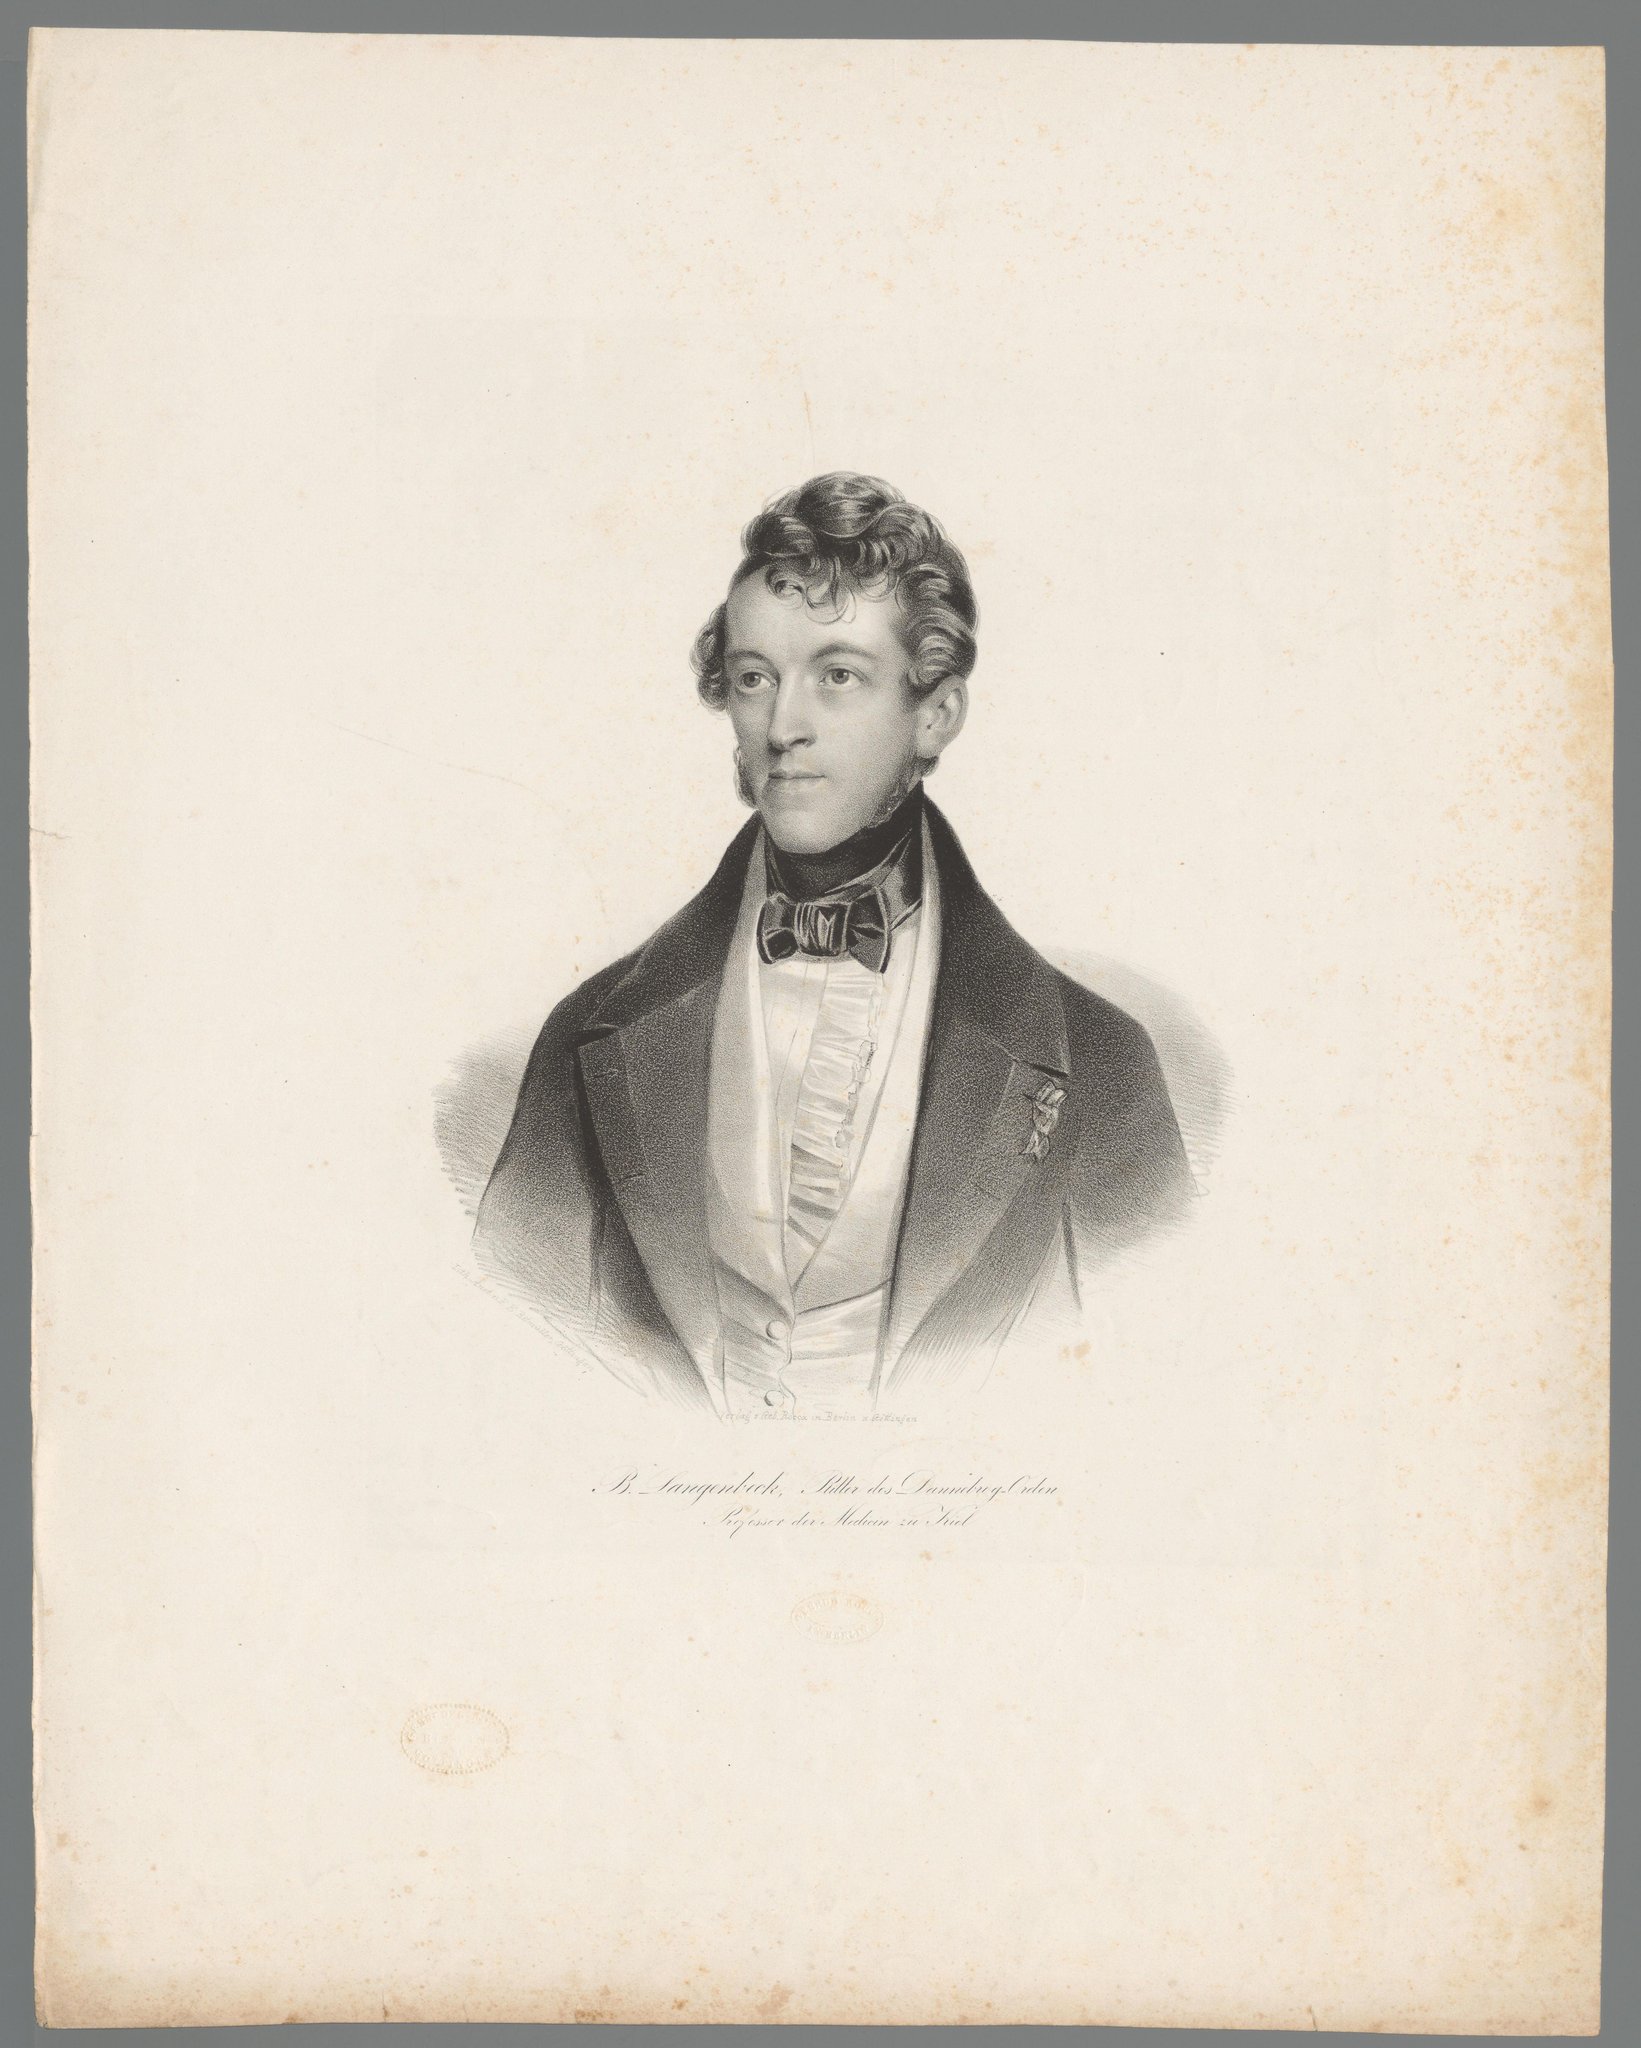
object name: print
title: Portret van Bernhard von Langenbeck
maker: friedrich eduard ritmüller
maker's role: printer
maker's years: 1805-1869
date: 1830-1863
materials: paper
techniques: lithograph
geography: gottingen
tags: barber; surgeon (+ portrait of scholar, scientist), historical persons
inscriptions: check stamp: Lugt 2141c, check stamp: Lugt 5514, collector's mark: Lugt 2228